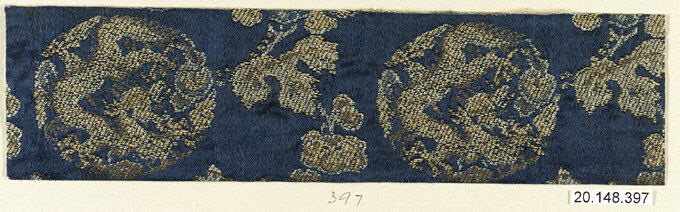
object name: piece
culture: japanese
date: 1701-1800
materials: silk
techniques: compound weave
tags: dragons